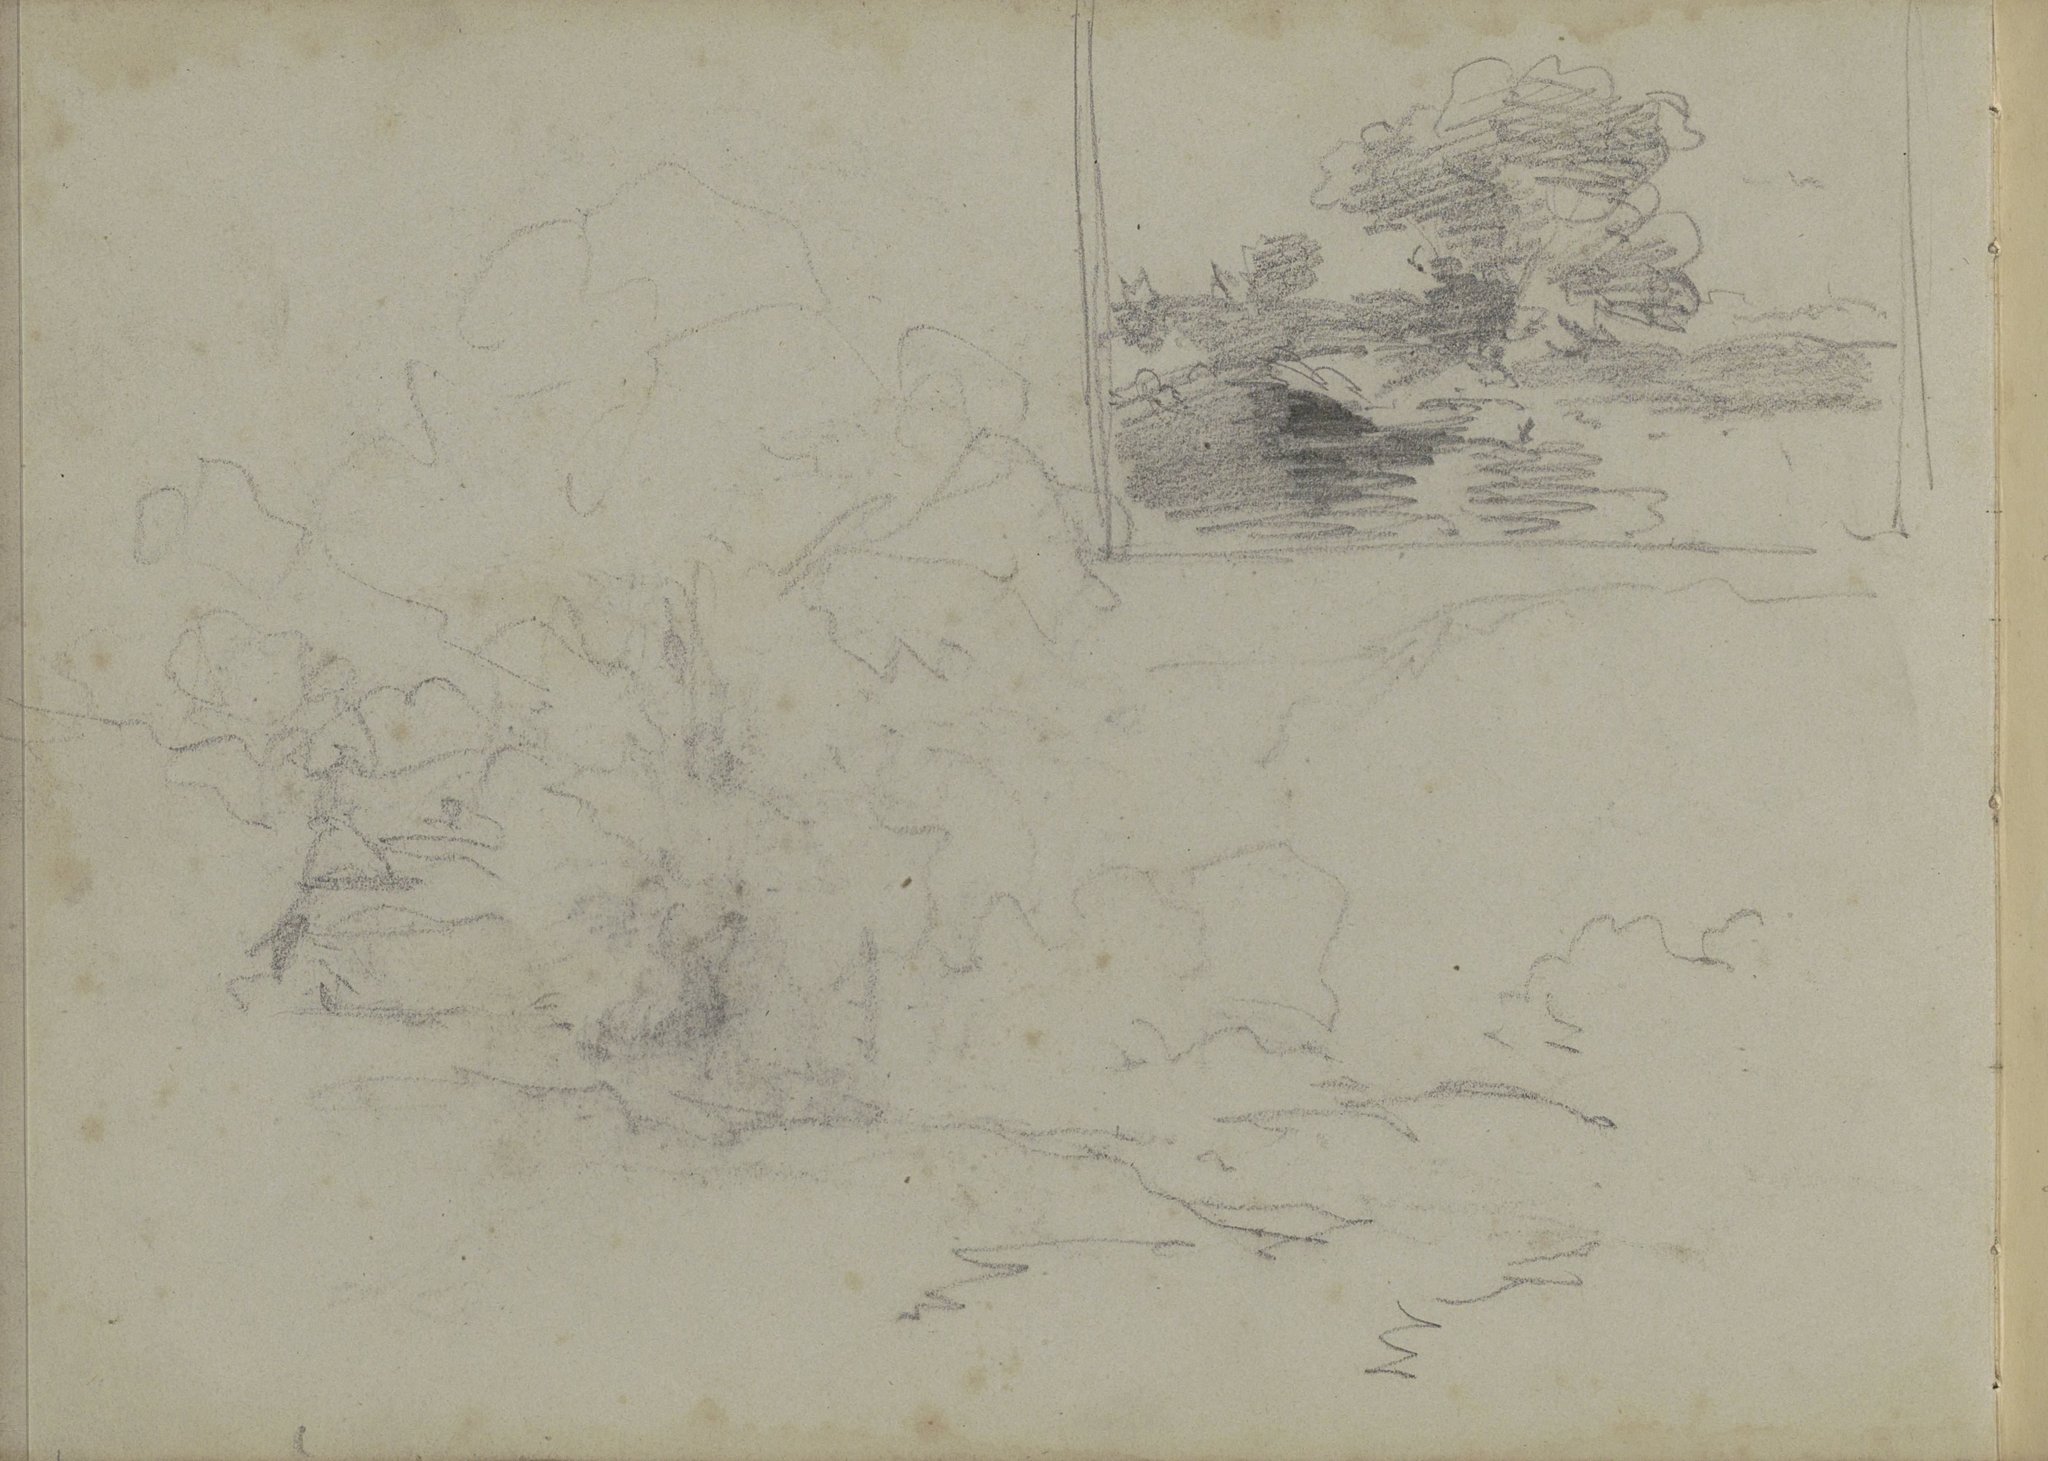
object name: sketchbook leaf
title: Landschappen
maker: willem roelofs (i)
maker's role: draughtsman, painter, print maker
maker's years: 1822-1897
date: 1846-1851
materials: paper, pencil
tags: landscapes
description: Blad 12 verso uit een schetsboek met 25 bladen.